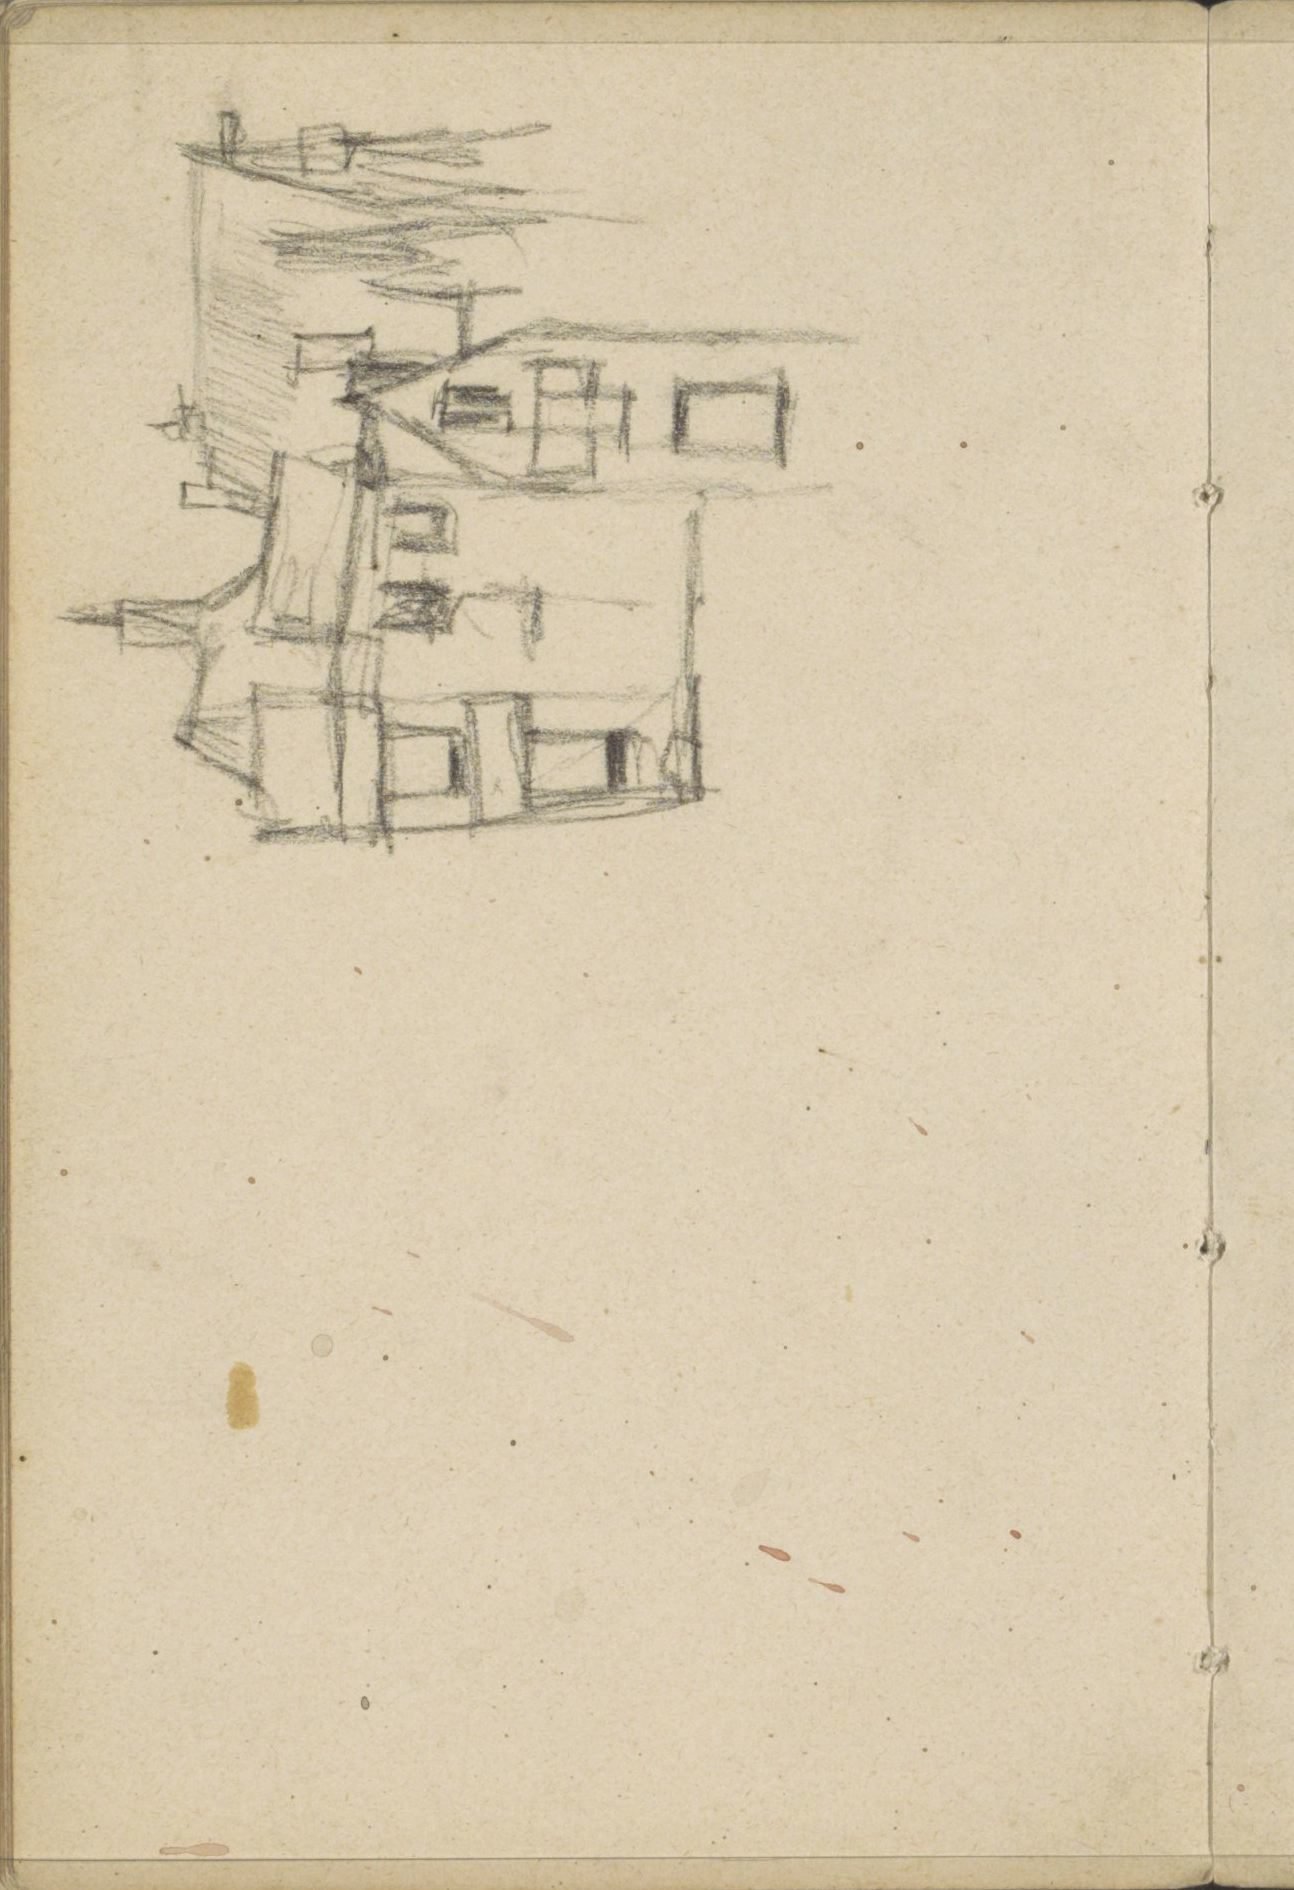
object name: sketchbook leaf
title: Gezicht op gebouwen, waarschijnlijk in Amsterdam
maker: george hendrik breitner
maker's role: draughtsman, painter, print maker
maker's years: 1857-1923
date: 1902-1914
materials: chalk, paper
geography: amsterdam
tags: urban housing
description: Gezicht op gebouwen, waarschijnlijk in Amsterdam. Pagina 81 uit een schetsboek met 46 bladen vervaardigd te Noord-Holland en Utrecht.